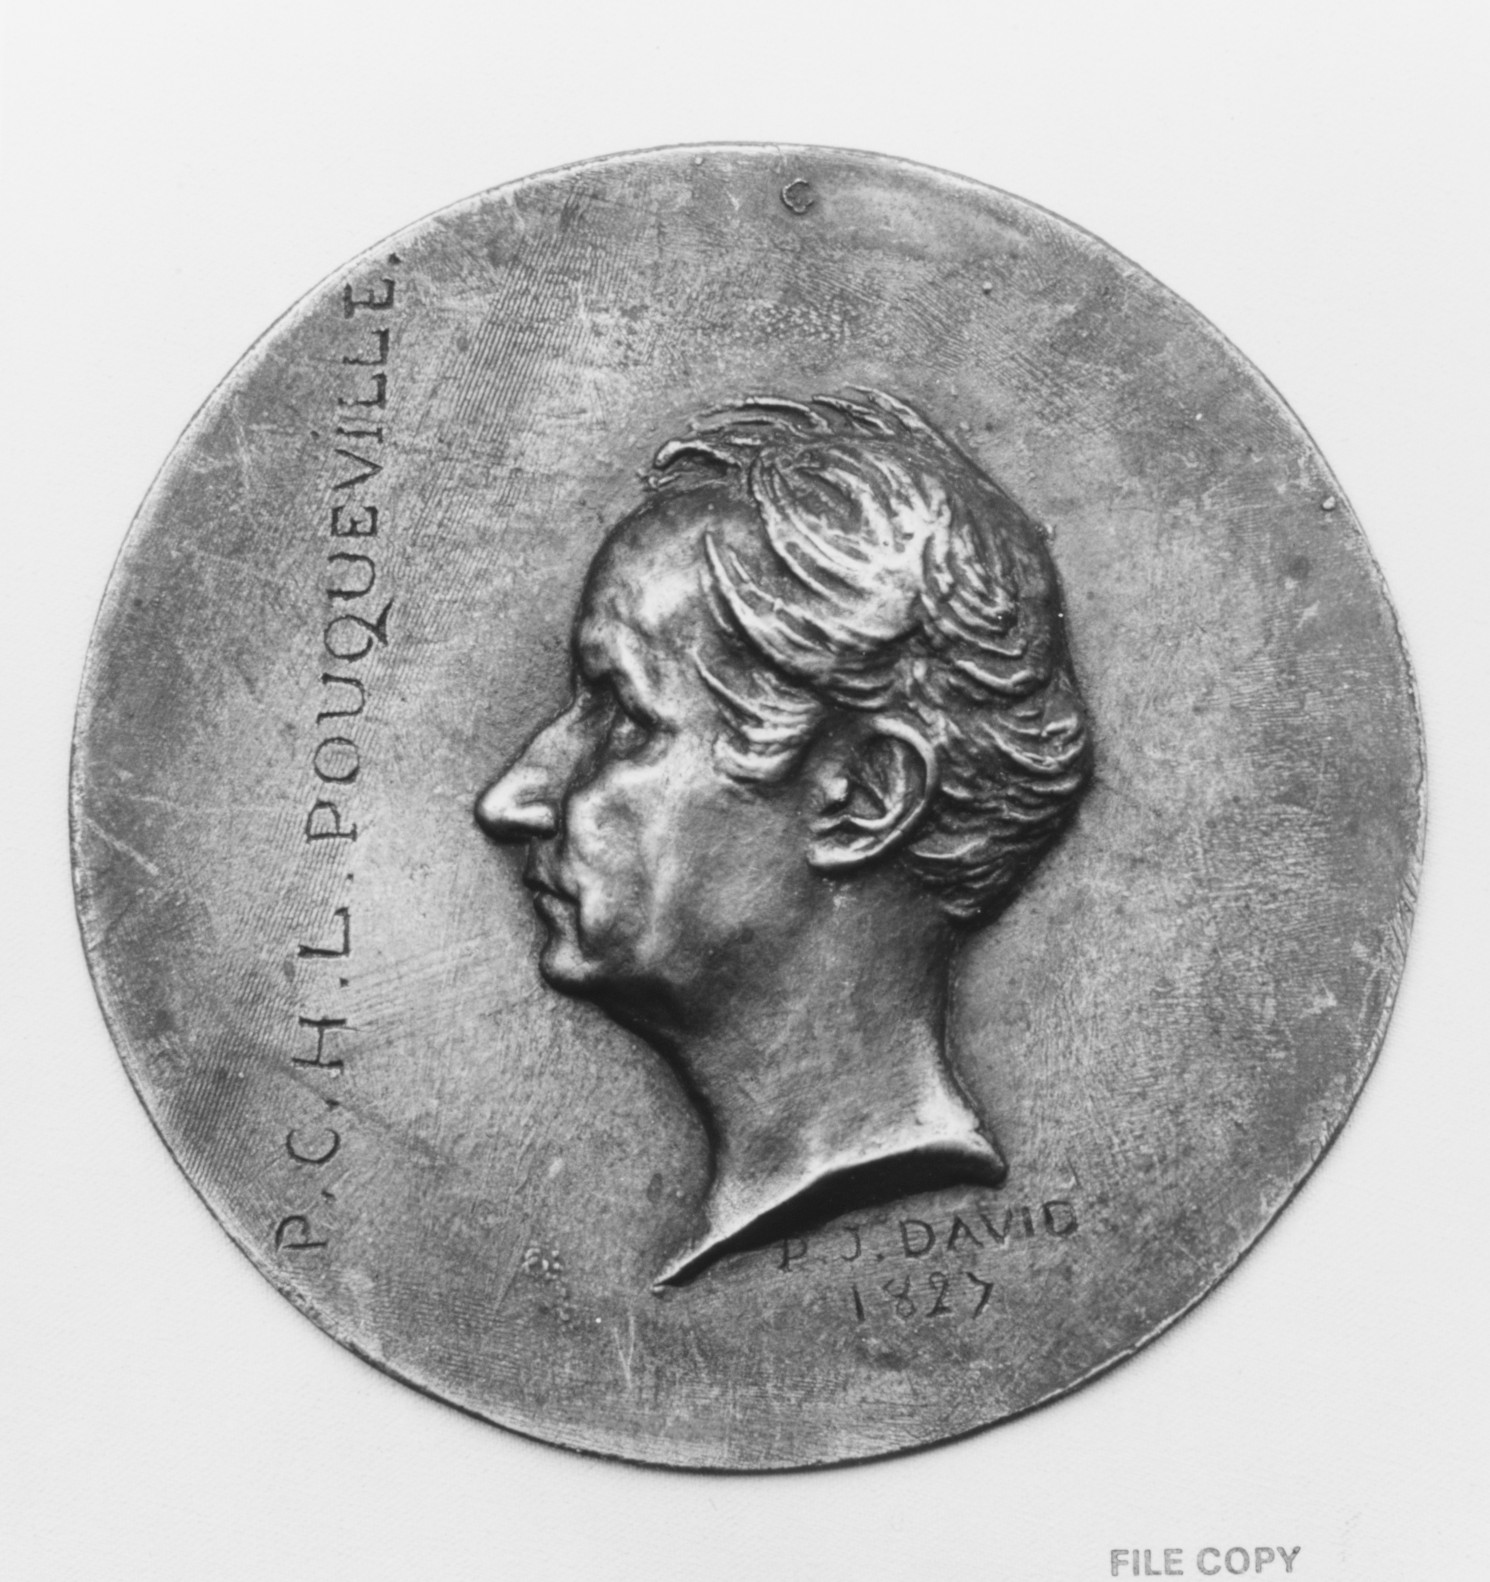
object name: medallion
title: François Charles Hugues Laurent Pouqueville (1770–1838), French traveler in the Orient and man-of-letters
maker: pierre jean david d'angers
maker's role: artist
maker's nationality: french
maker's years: 1788-1856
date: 1827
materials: bronze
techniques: casting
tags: men,profiles